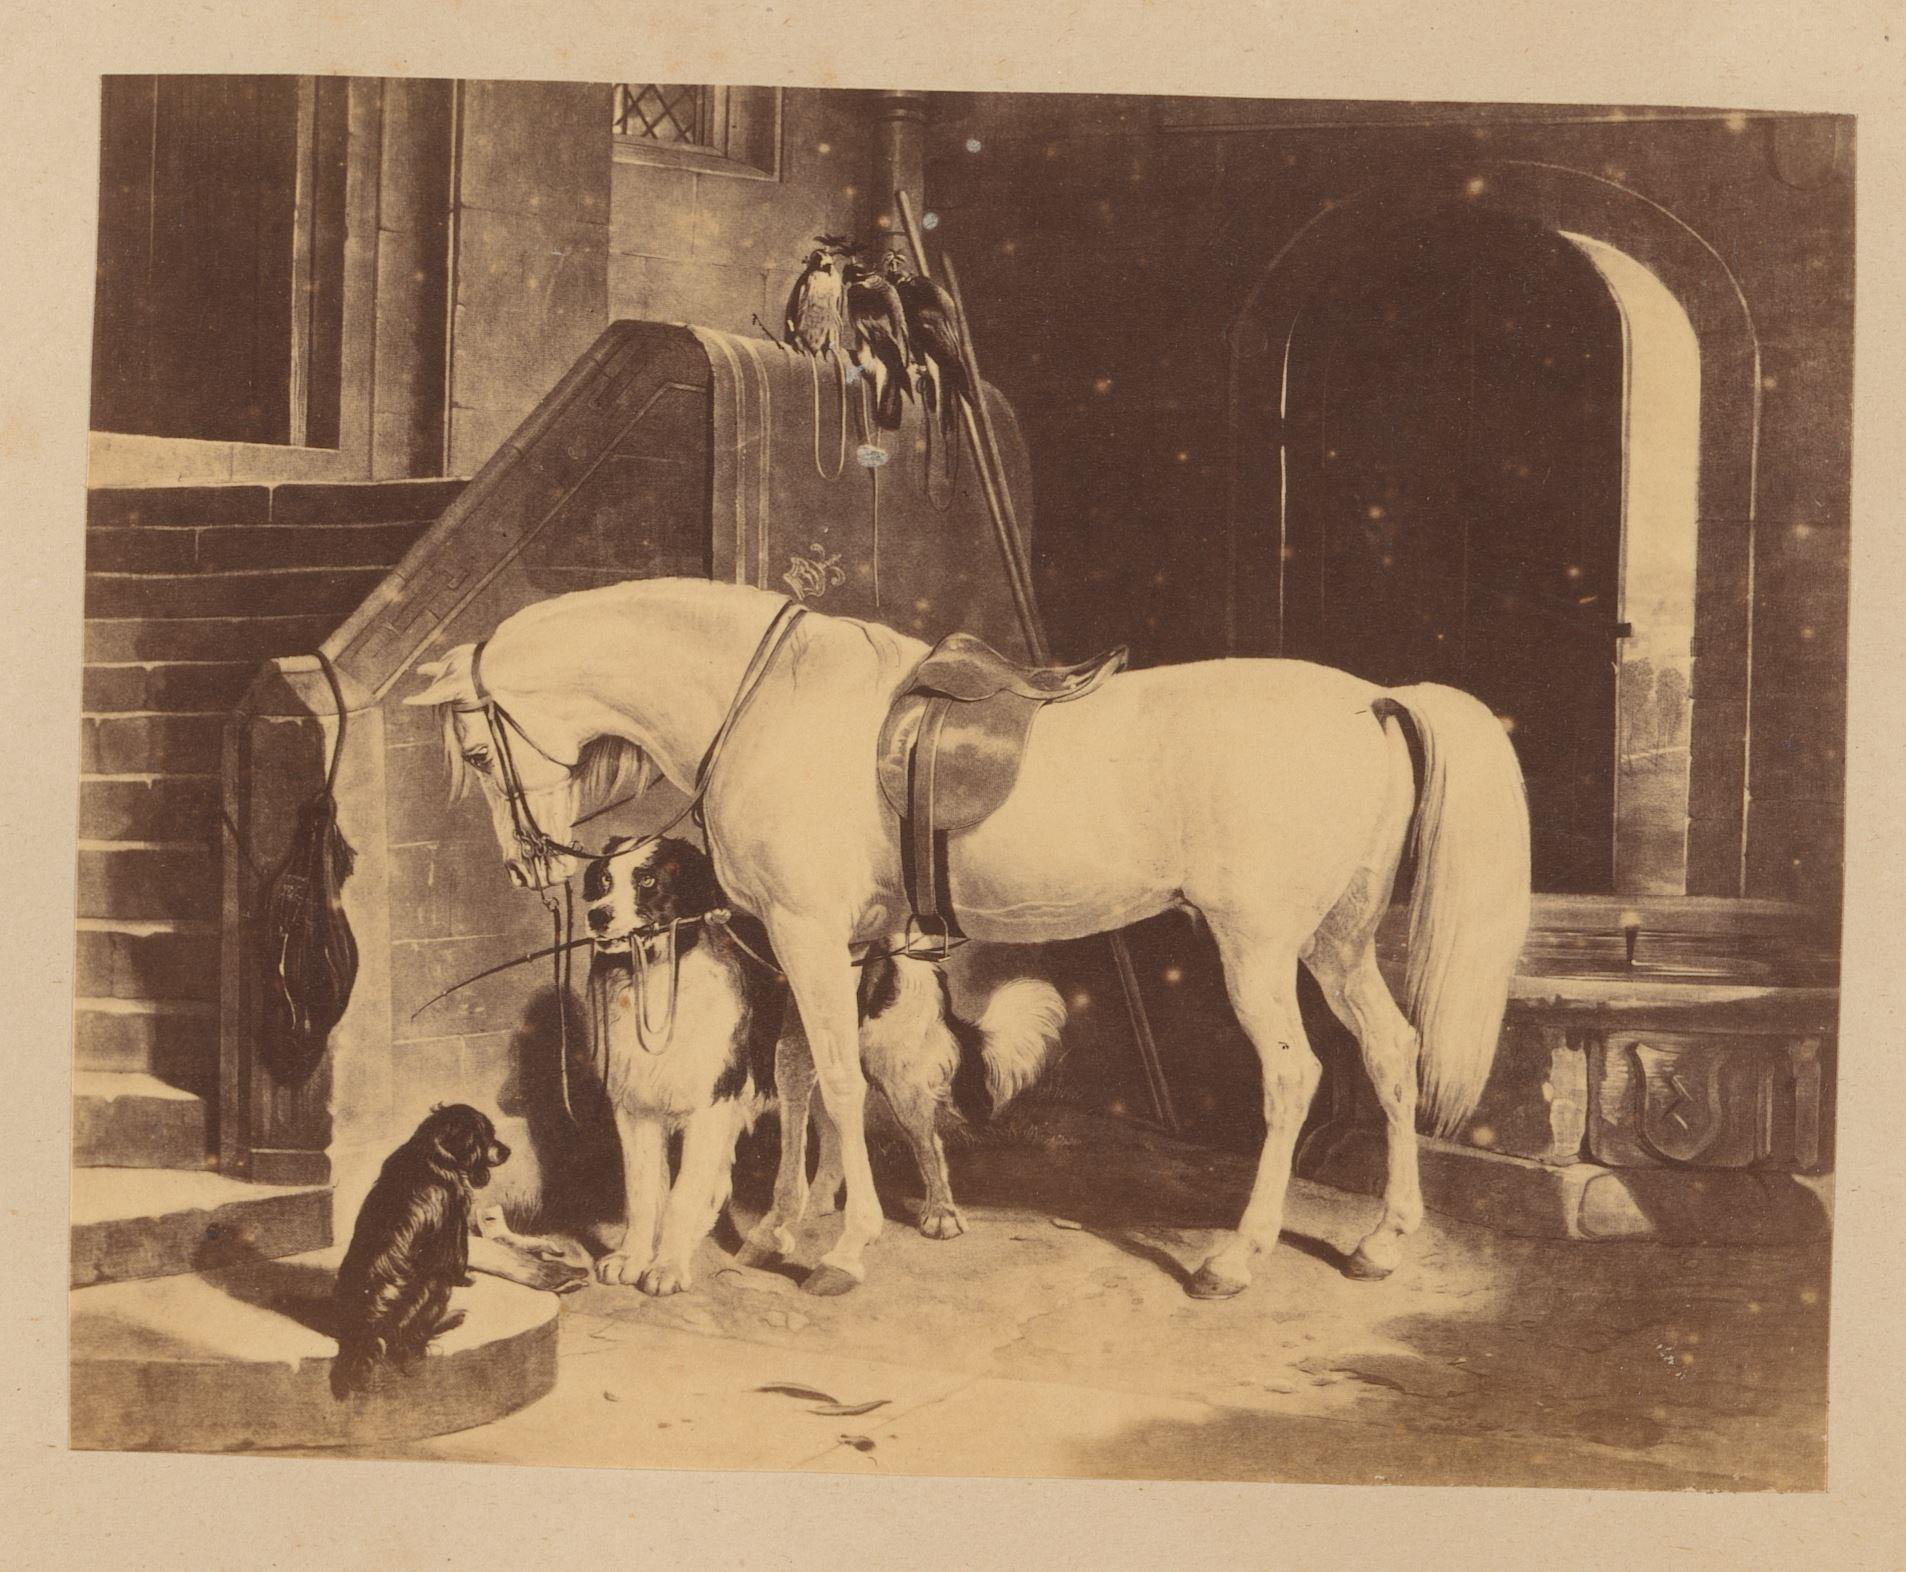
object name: reproduction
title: Fotoreproductie van een schilderij van een binnenplaats met een paard, jachtvogels en twee honden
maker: Anonymous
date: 1875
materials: photographic support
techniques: albumen print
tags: predatory birds, horse, dog